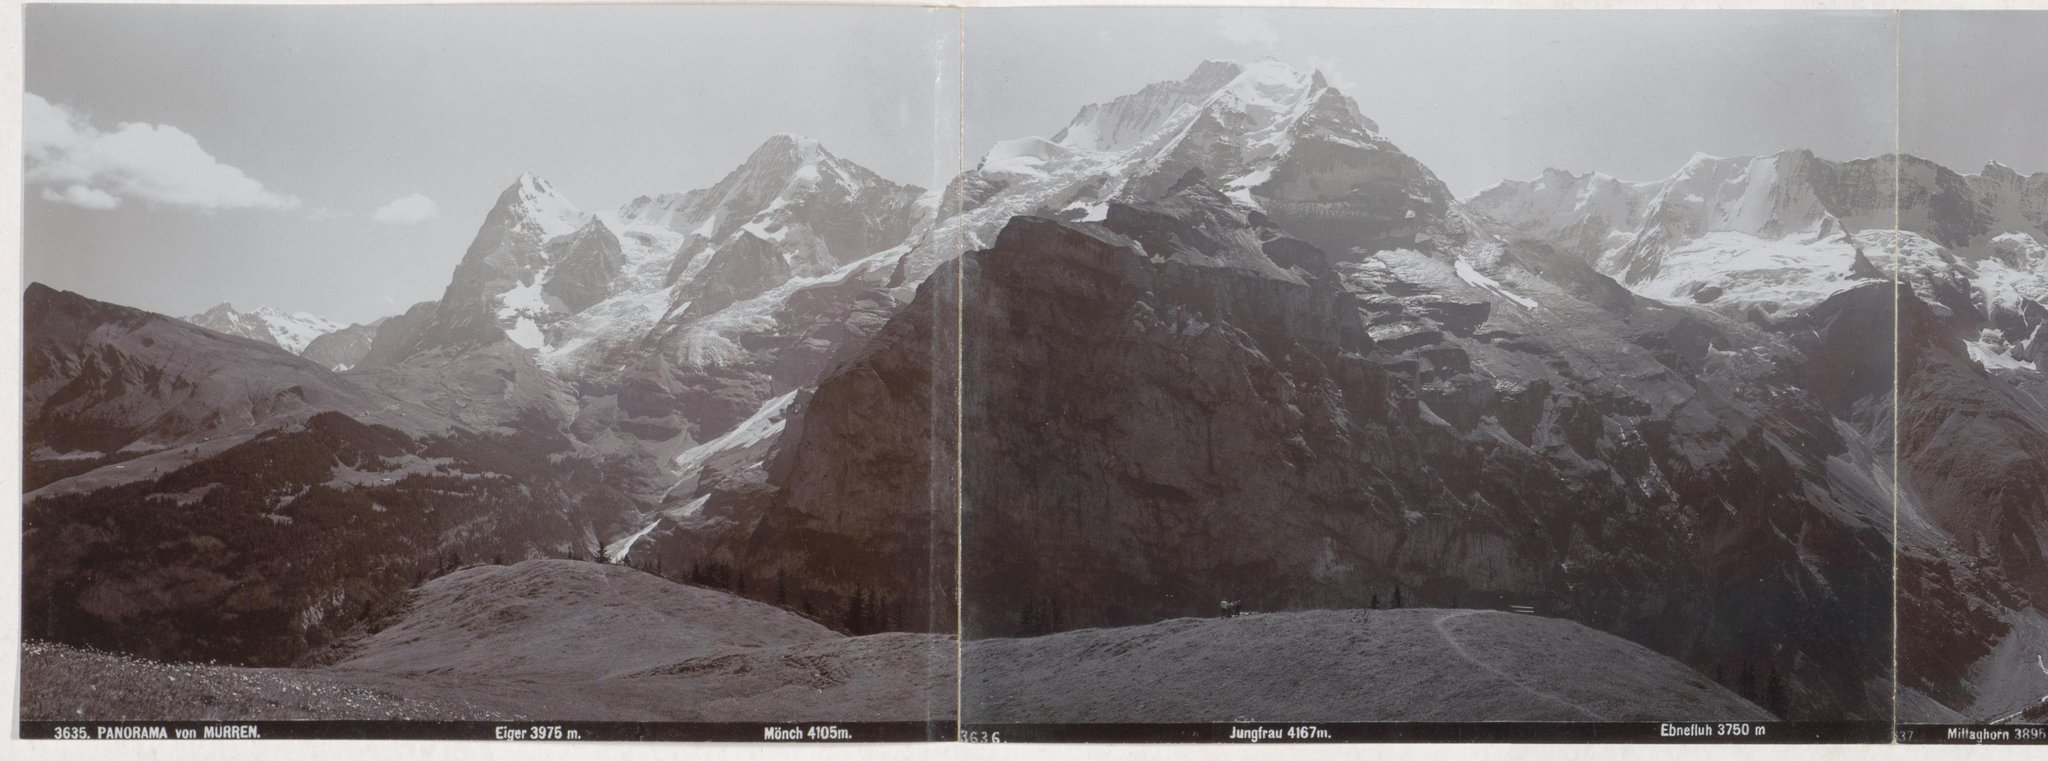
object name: photograph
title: Panorama van de Alpen nabij Mürren met de Eiger, Mönch en de Jungfrau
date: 1896-1897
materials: paper, photographic support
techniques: collodion silver print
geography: mürren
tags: mountain-range, snow peaks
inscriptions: inscription: ‘Gebr. Wehrli, Photographen/ Kilchberg b/Zürich’, inscription: ‘Panorama von Murren. Eiger 3975 m. Monch 4105 m. Jungfrau 4167 m. Ebnefluh 3750 m. Mittaghorn 3895 m. Grosshorn 3765 m. Breithorn 3779 m. Gspaltenhorn 3487’, number: ‘4,-’